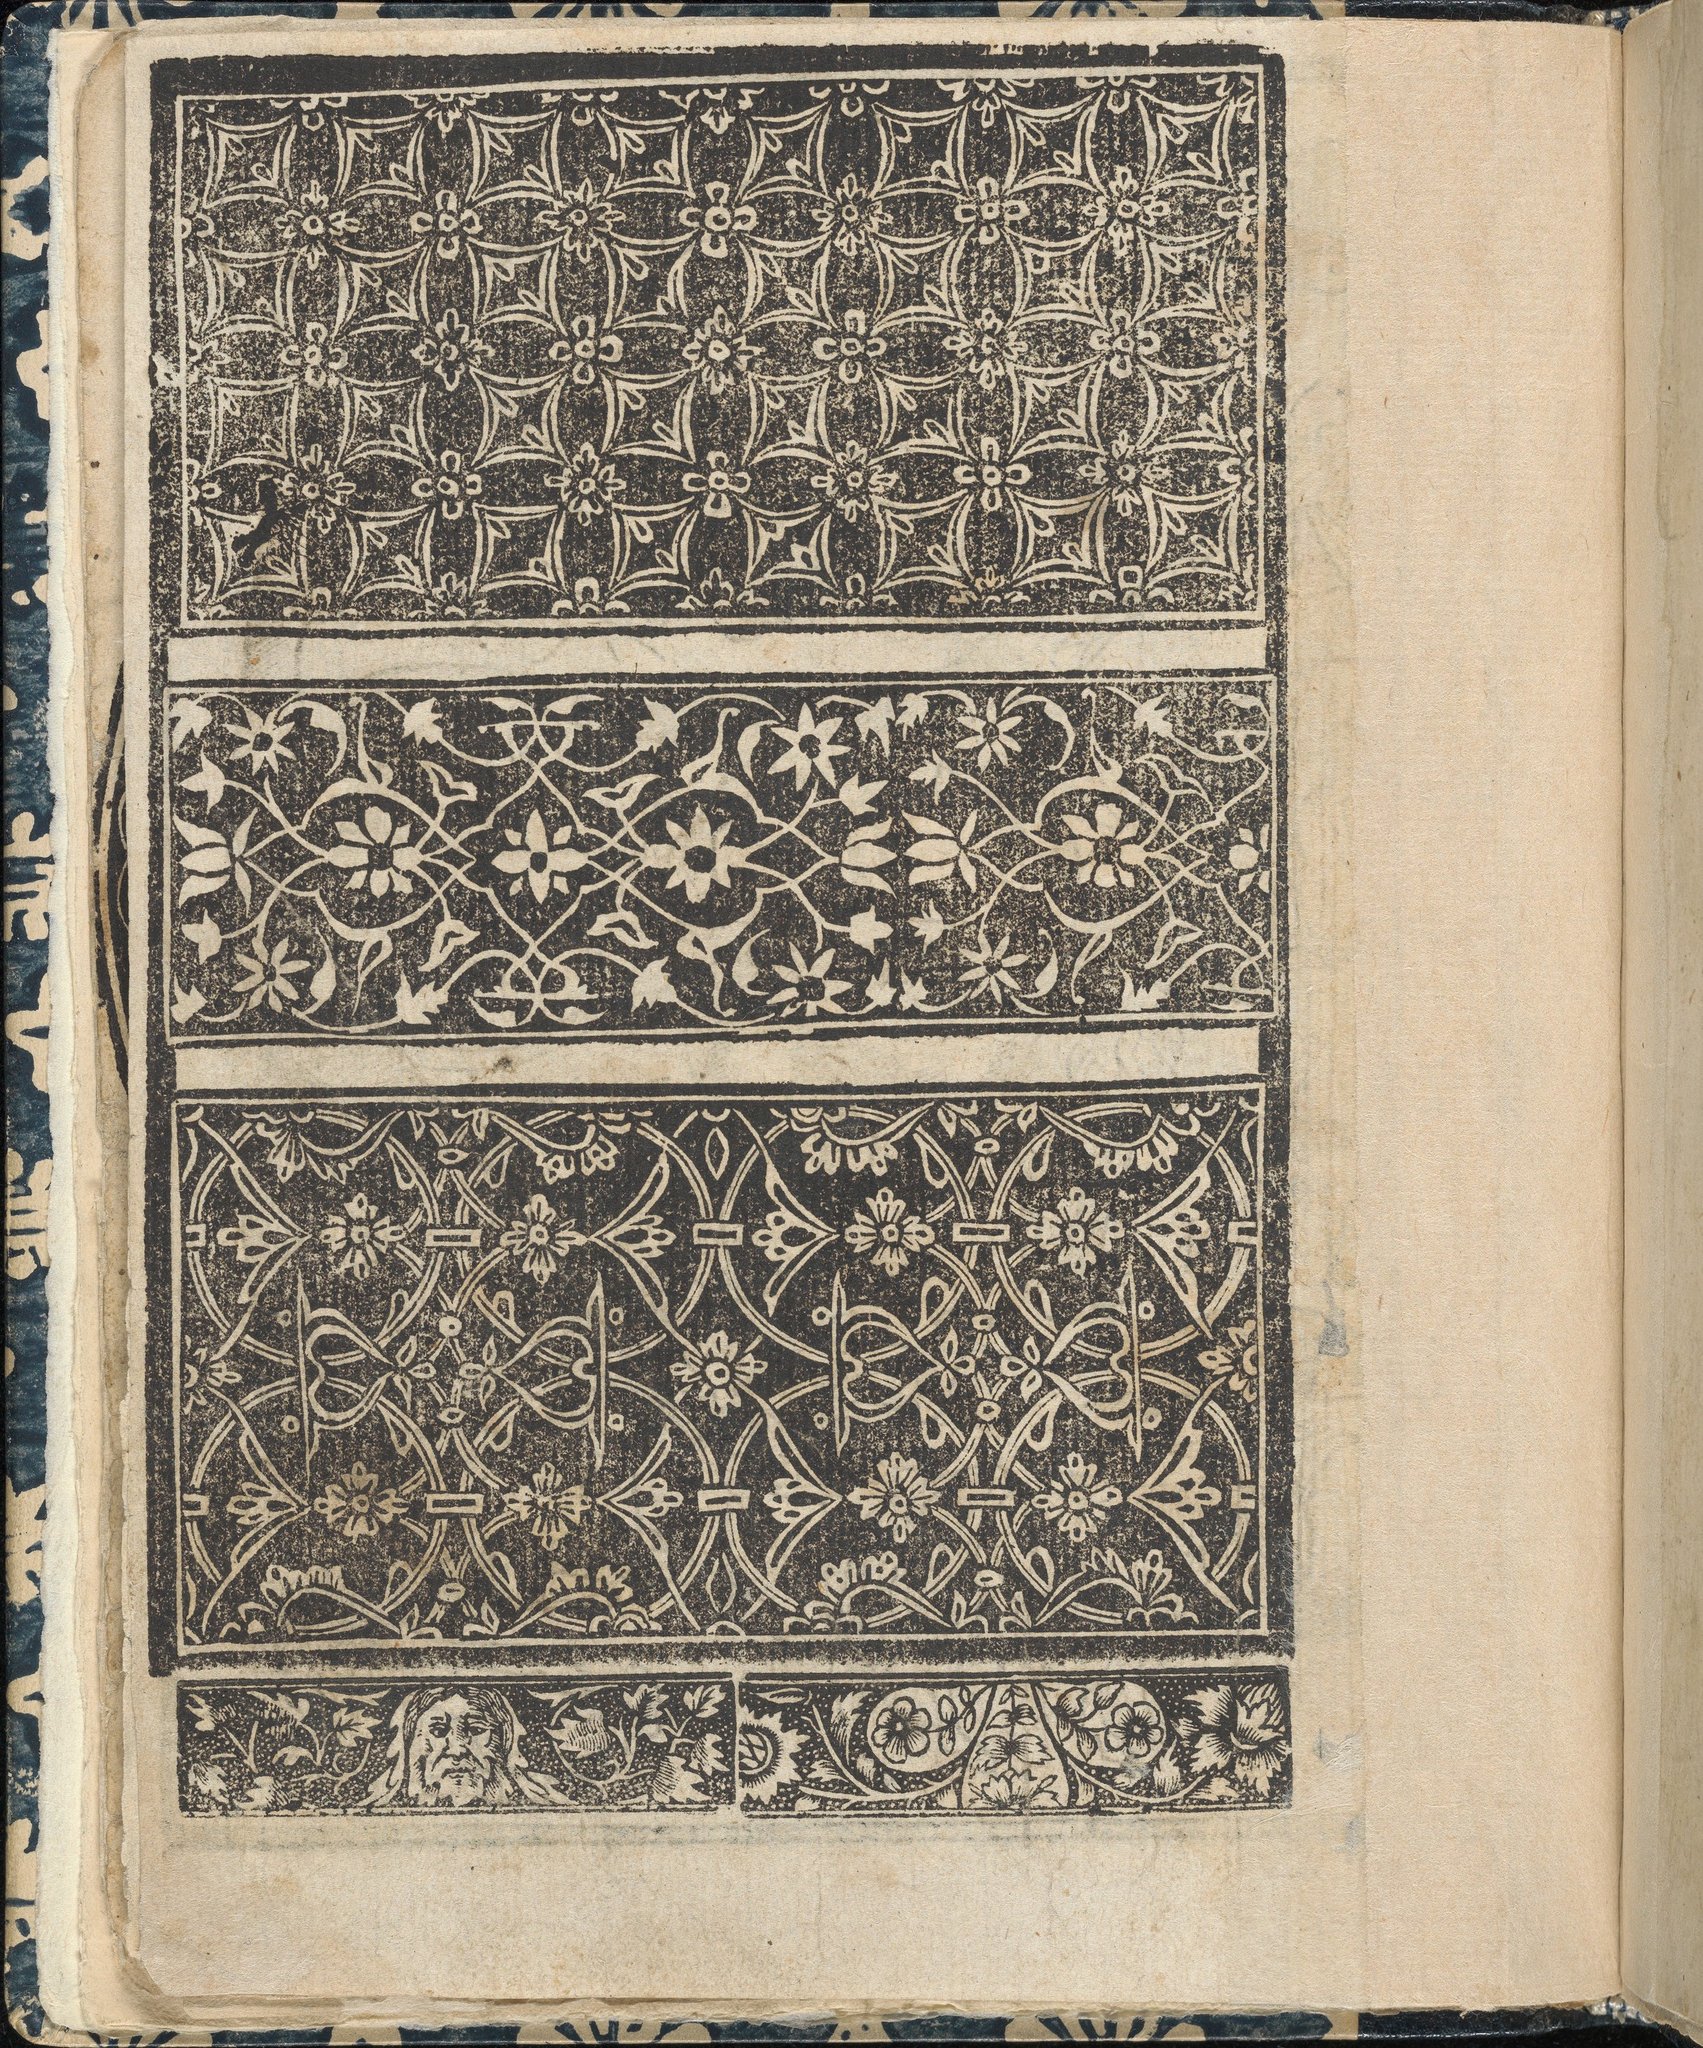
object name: book print ornament architecture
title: Essempio di recammi, page 13 (verso)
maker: giovanni antonio tagliente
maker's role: author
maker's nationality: italian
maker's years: 1465-1528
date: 1530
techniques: woodcut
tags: ornament